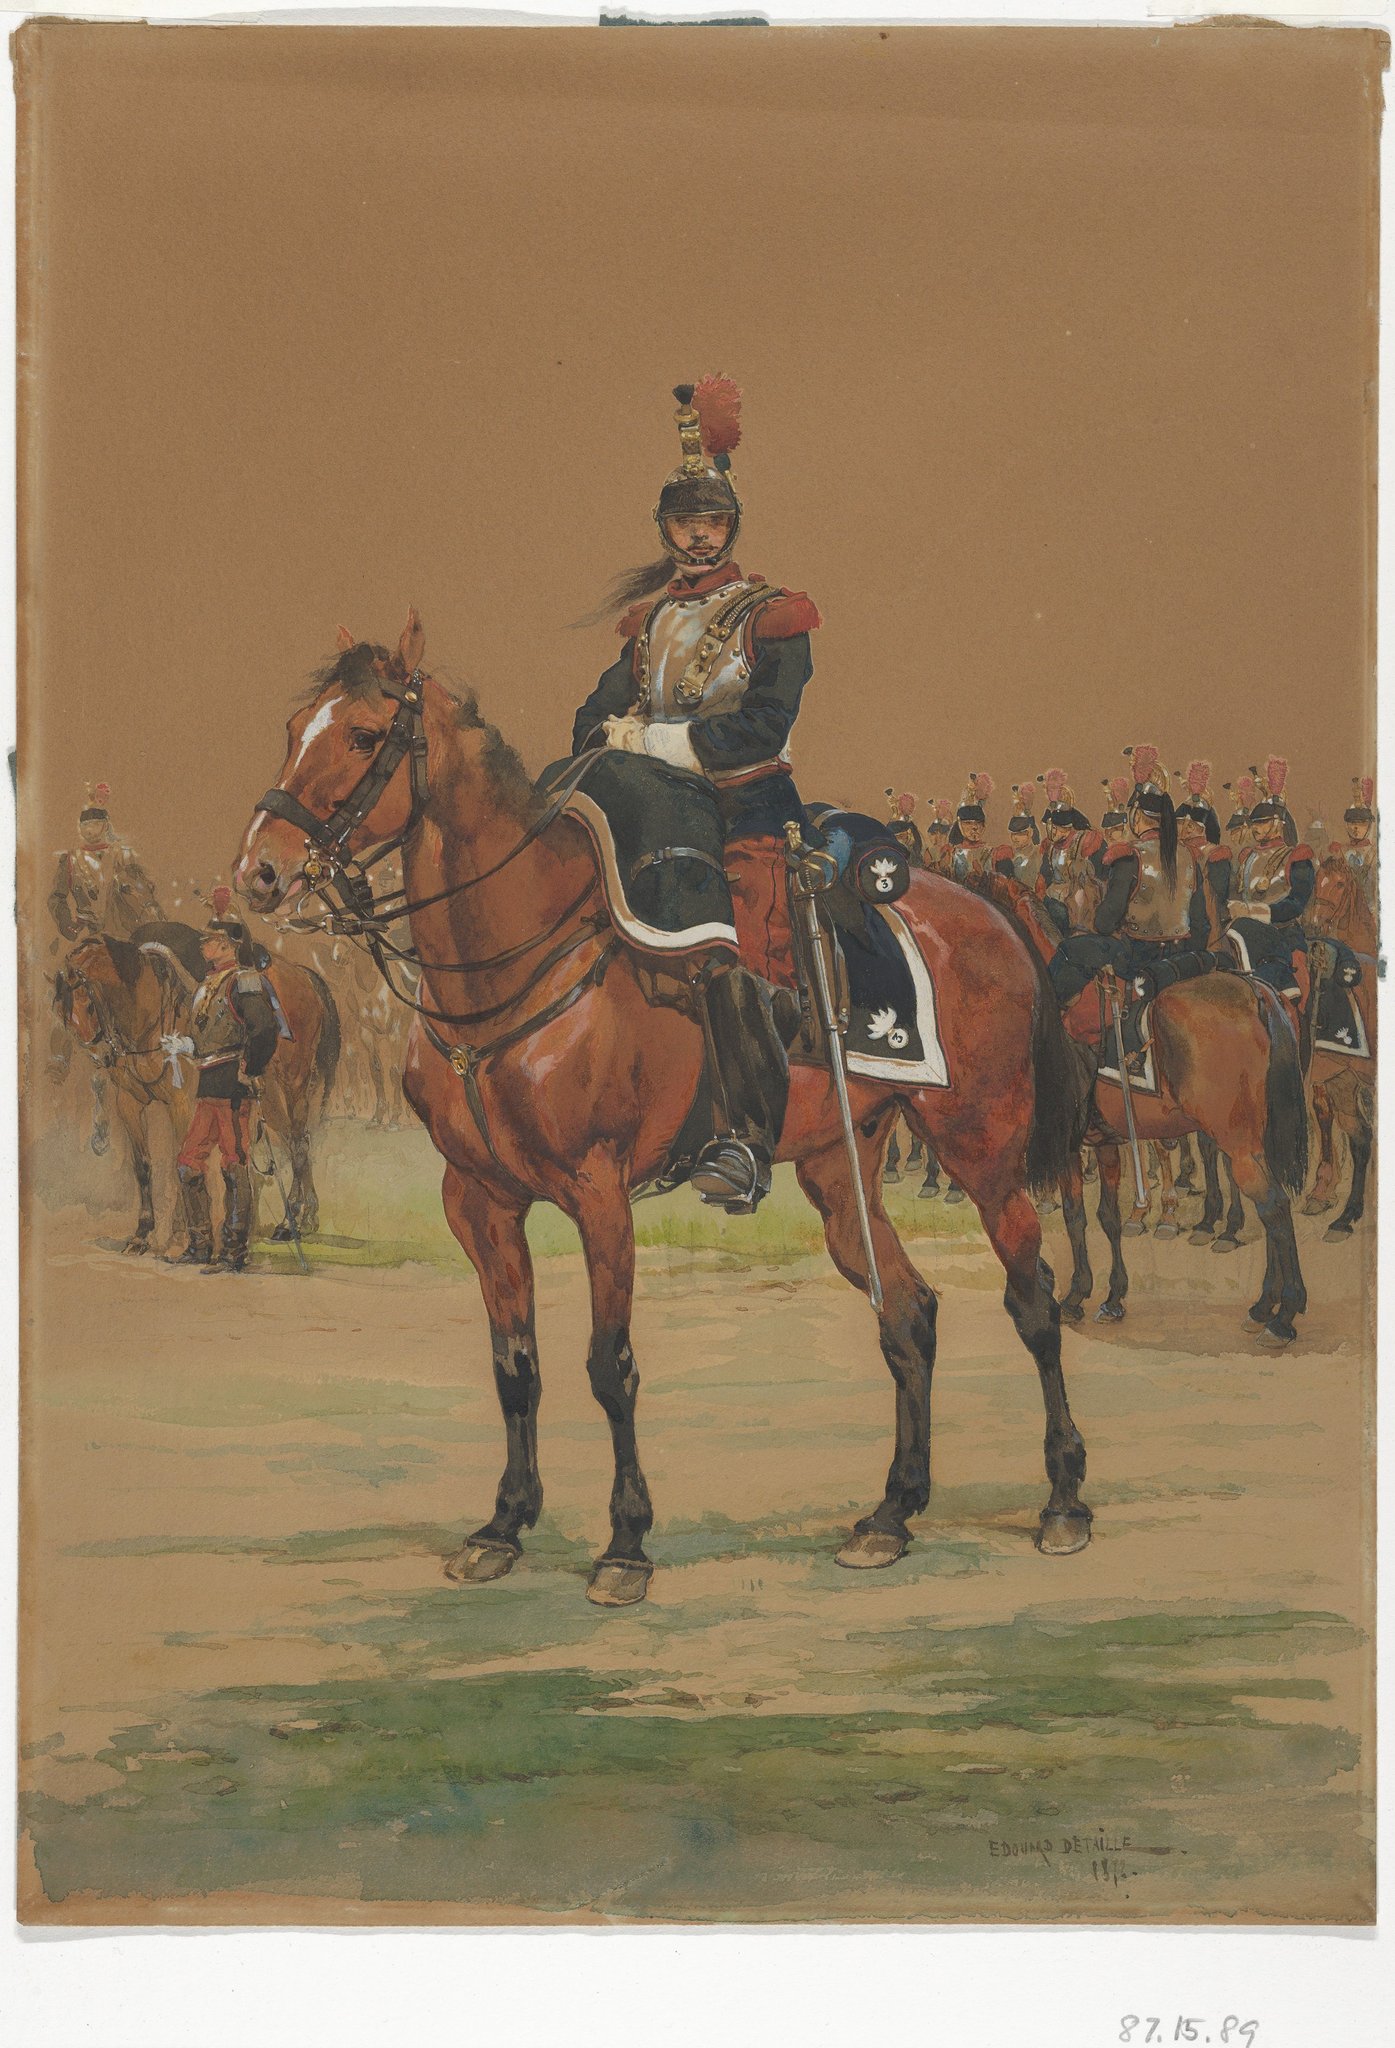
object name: drawing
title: French Cuirassier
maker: edouard detaille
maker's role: artist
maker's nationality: french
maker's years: 1848-1912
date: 1872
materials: watercolor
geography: france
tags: soldiers,horses